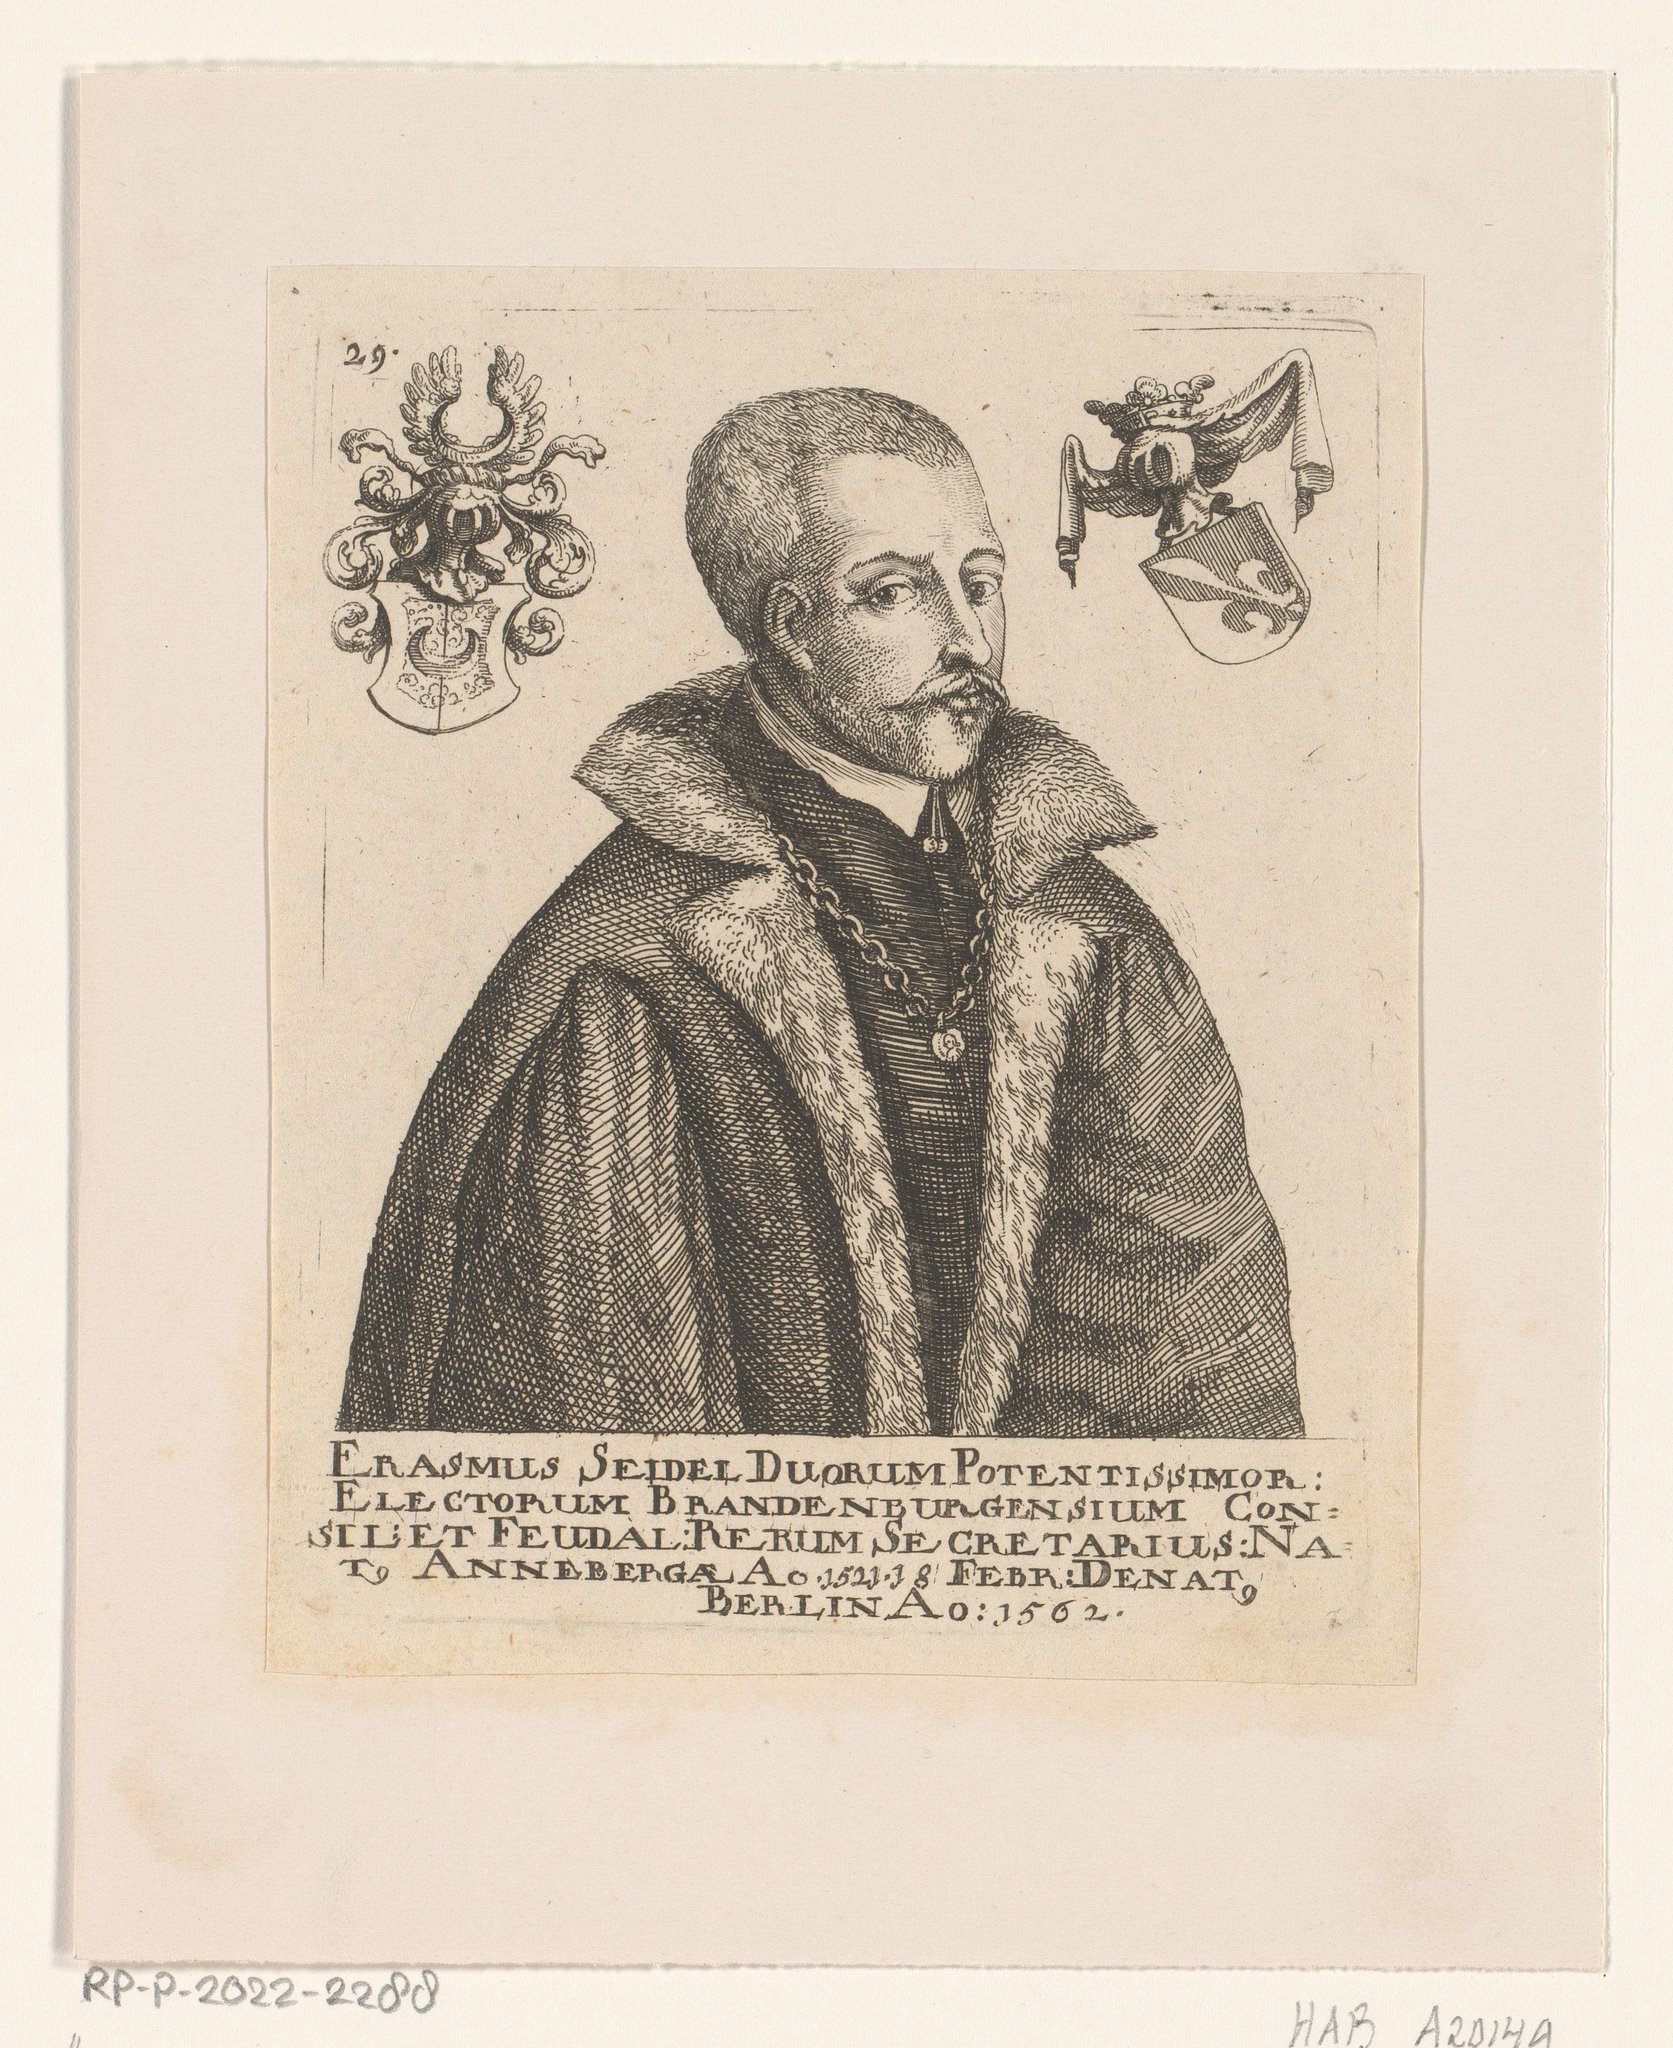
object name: print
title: Illustere mannen verzameld door Martin Friedrich Seidel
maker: Anonymous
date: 1671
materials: paper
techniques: etching, snipping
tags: historical persons, lawyer, attorney at law, politician, e.g. party leader, armorial bearing, heraldry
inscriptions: collector's mark: Lugt 2228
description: De prent is uitgegeven als onderdeel van een serie. Later is de prent mogelijk ook als boekillustratie gebruikt in: Küster, Georg Gottfried. Martin Friedrich Seidels Bilder-Sammlung in welcher hundert, gröstentheils in der Mark Brandenburg (…). Berlijn: Buchladen bey der Real-Schule, 1751. Het is onduidelijk tot welke uitgave de huidige prent behoort.